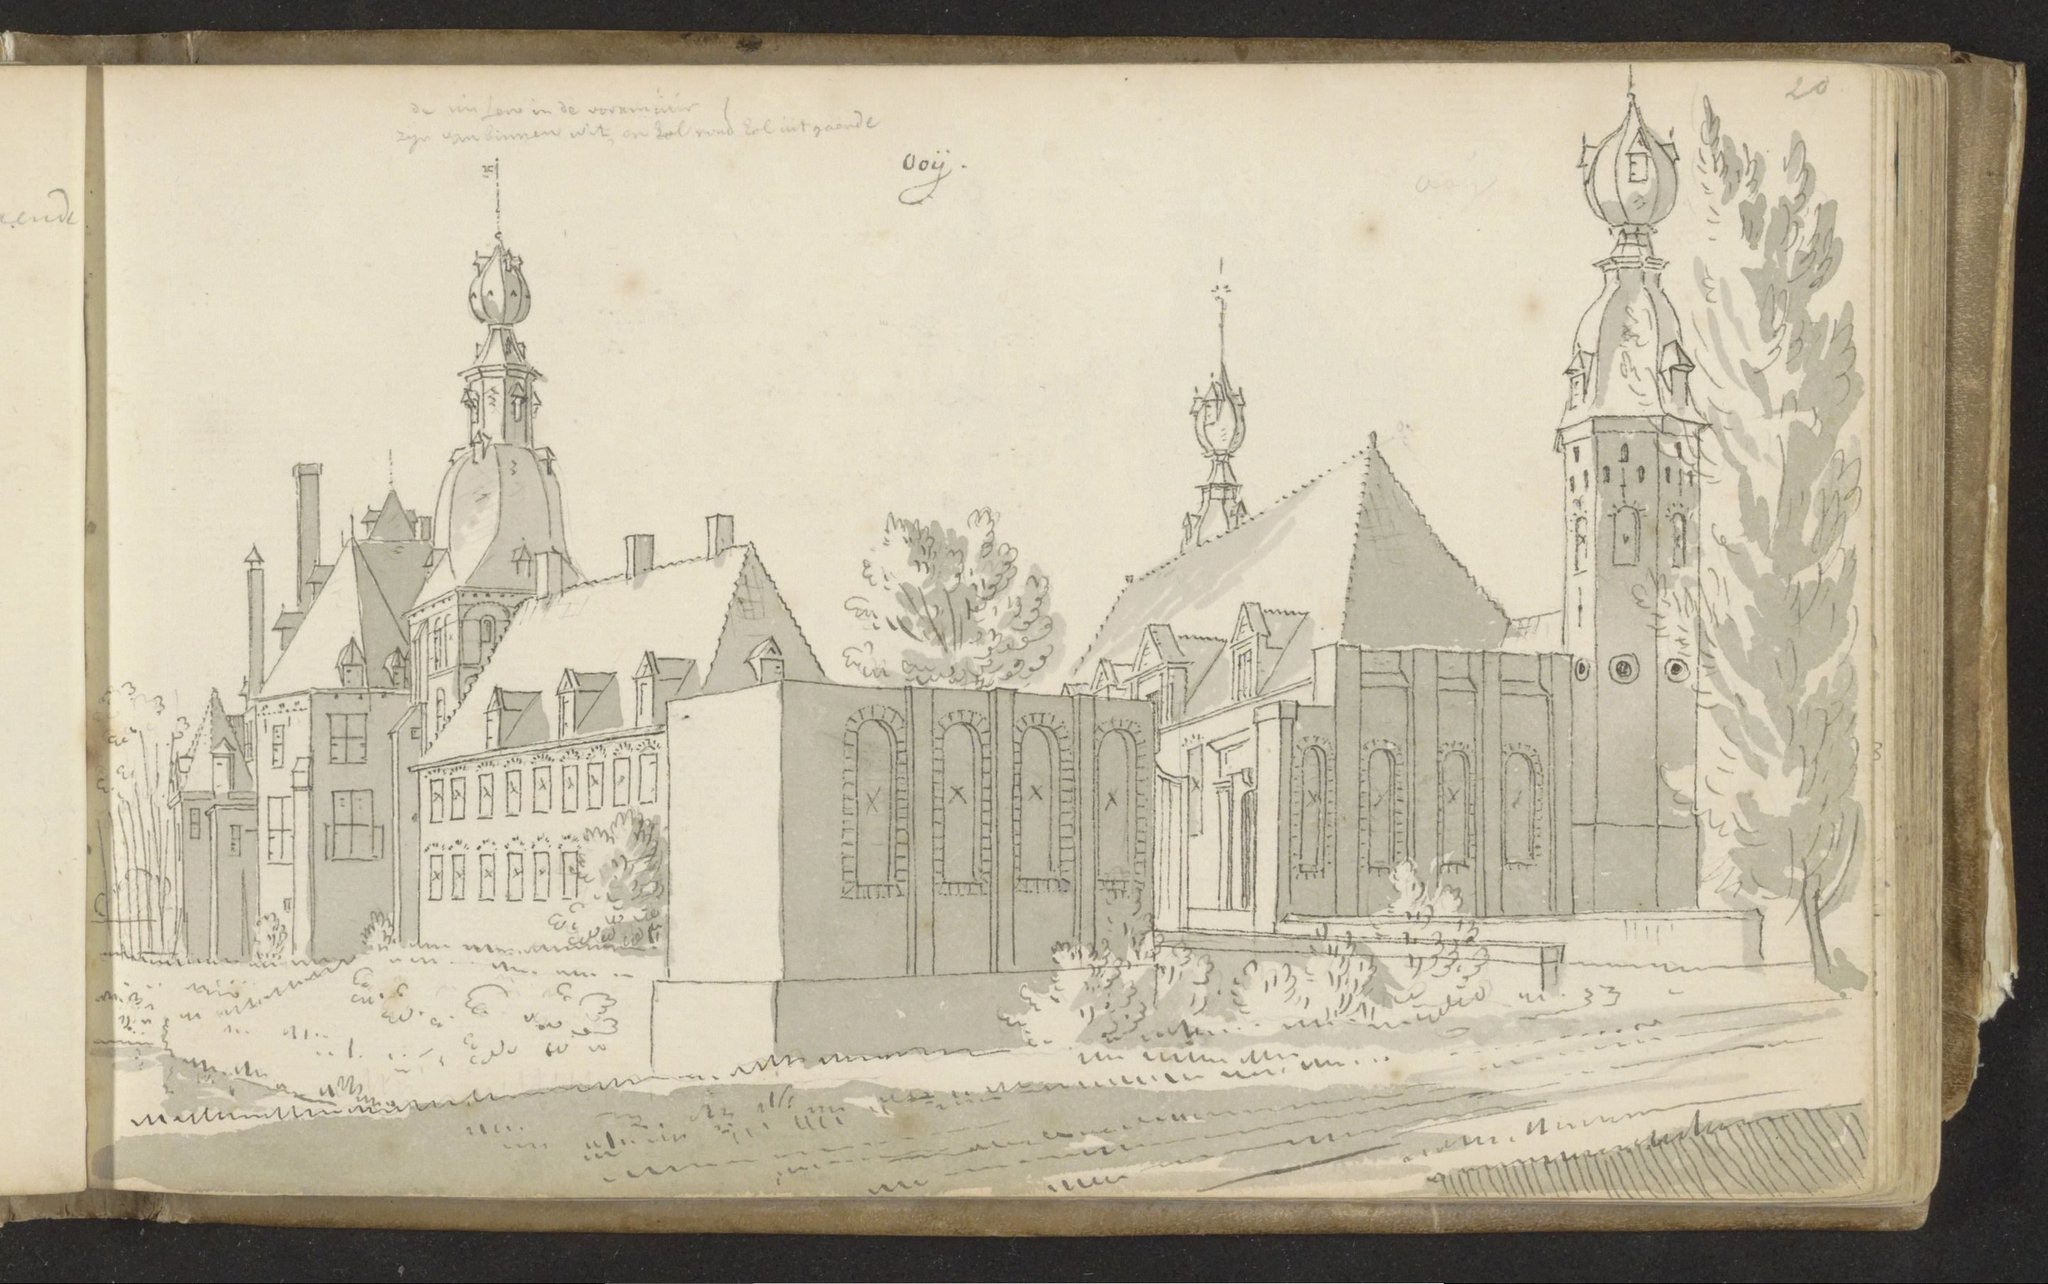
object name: sketchbook leaf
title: Kasteel Ooij te Ooij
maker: abraham de haen (ii)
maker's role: draughtsman, print maker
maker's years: 1707-1748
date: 1731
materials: ink, paper, pencil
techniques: brush, pen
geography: ooy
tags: castle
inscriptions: annotation: ‘de nissen in de voormuur/ zijn van binnen wit en hol rond hol uitgaande/ Ooij’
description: Blad 20 recto uit een schetsboek met 69 bladen.